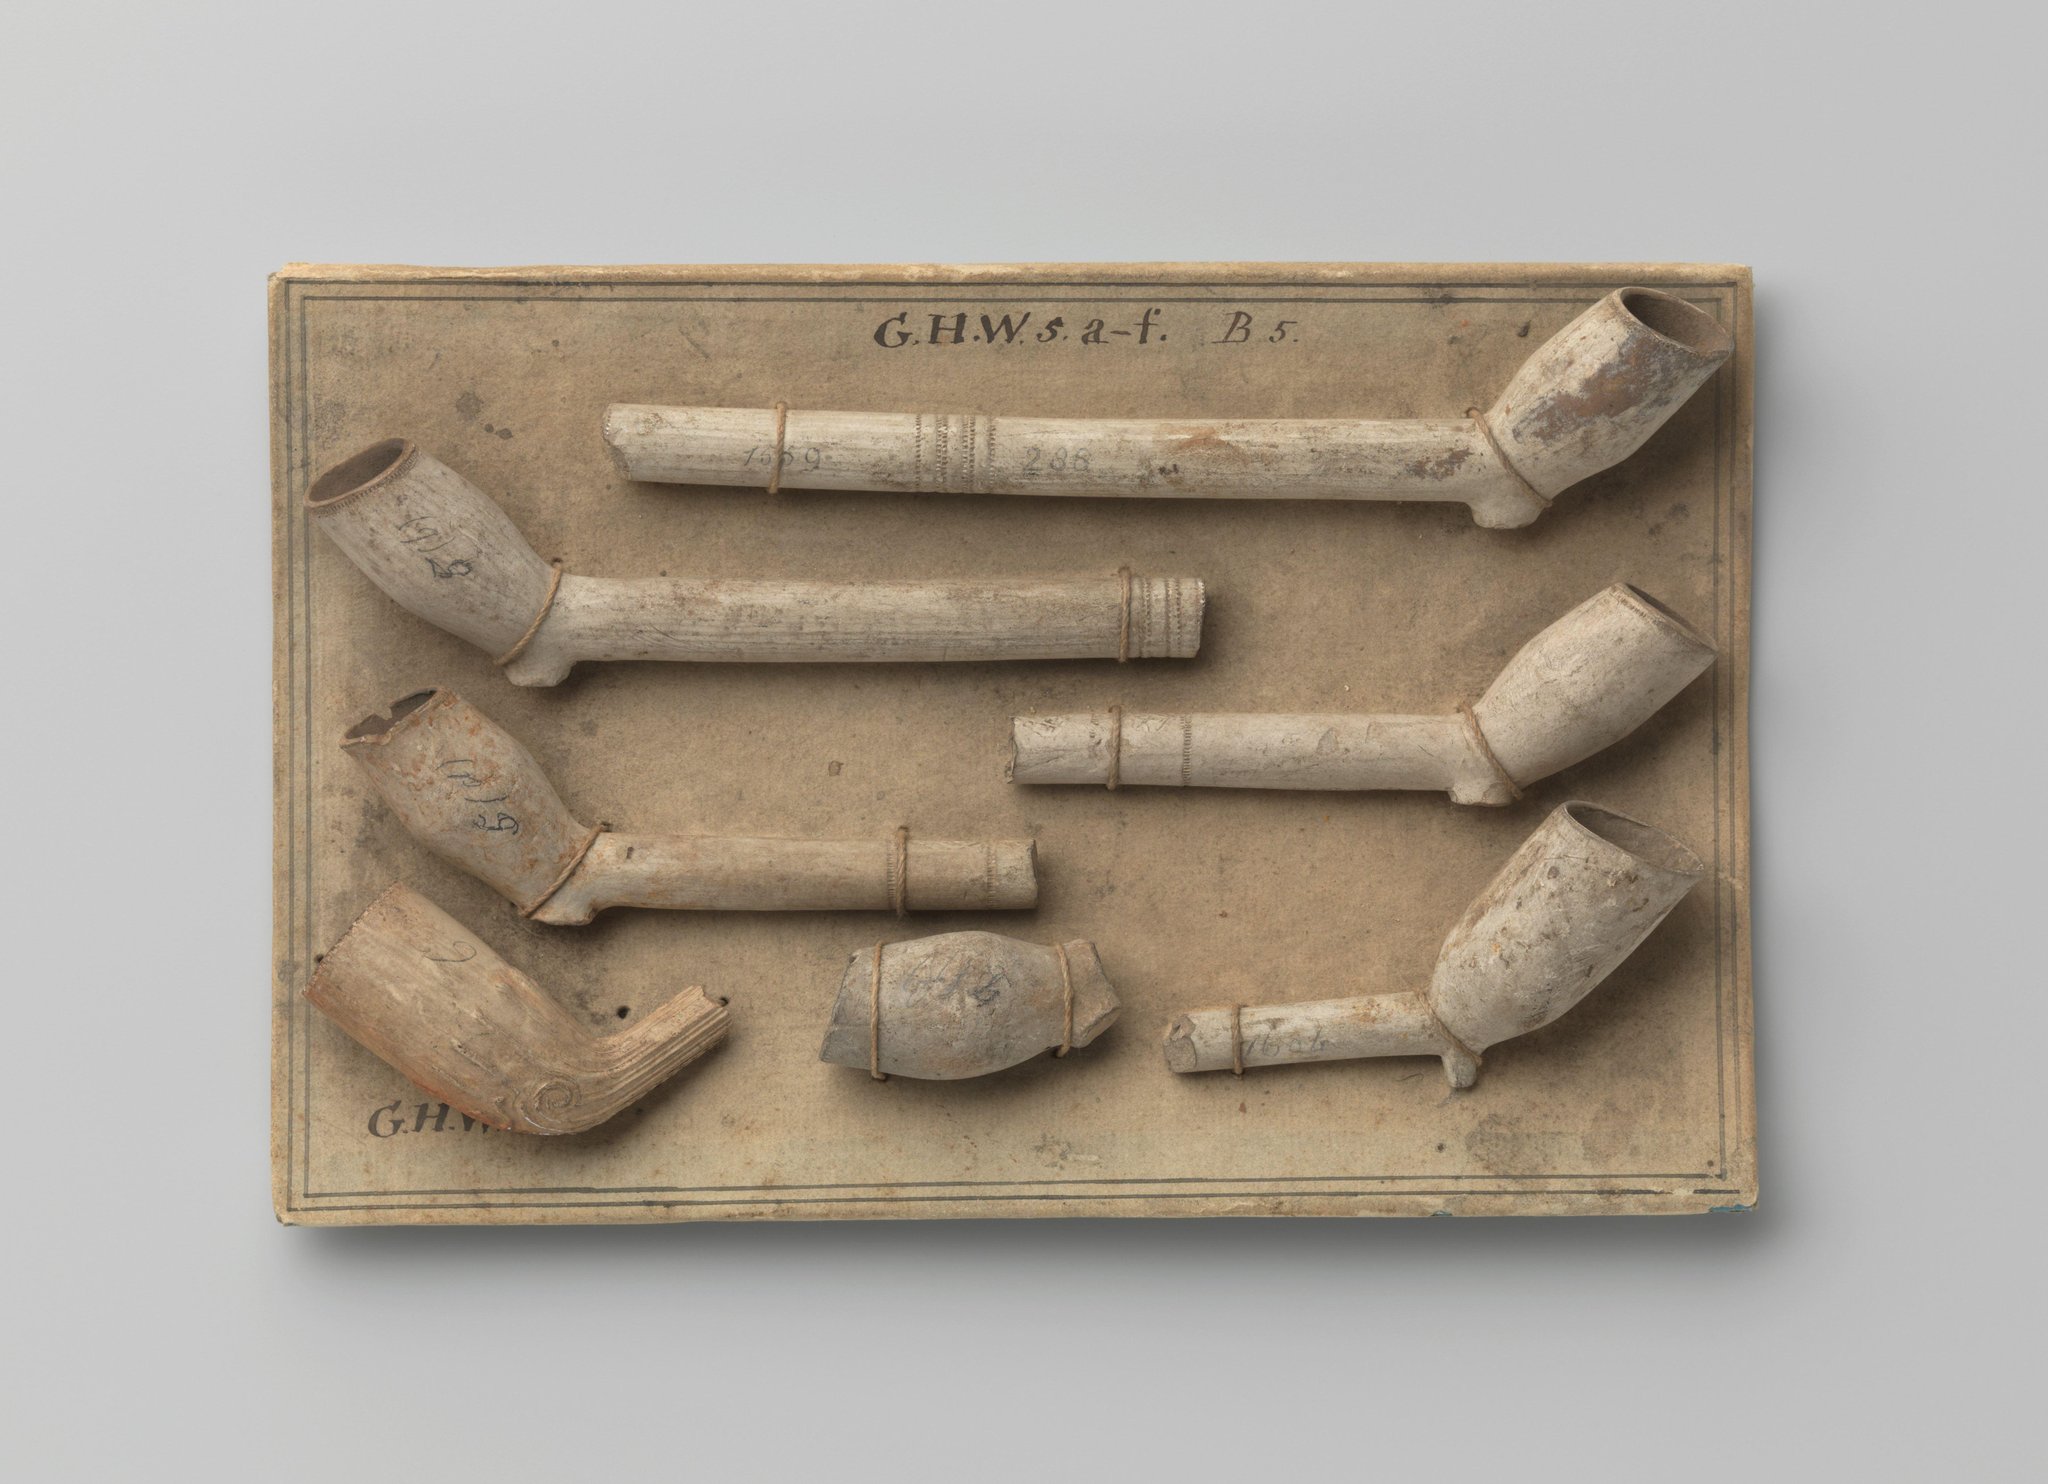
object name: pipe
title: Pijpenkop van pijpaarde.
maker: Anonymous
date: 1600-1800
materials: earthenware, clay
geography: gouda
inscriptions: : ‘G.H.W.6’, : ‘G.H.W.5 a-f B5’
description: Pijpenkop van pijpaarde. De pijpenkop is onderdeel van een serie van zeven pijpenkoppen (BK-NM-6, BK-NM-5-1 t/m BK-NM-5-6), die op een karton, voorzien van een opschrift (G.H.W.5. en G.H.W.6: initialen van de oorspronkelijke verzamelaar Heinrich Gottfried Haasloop Werner (Kleef 16 april 1792-Elburg 29 september 1864), met volgnummers), zijn gemonteerd. Zes koppen hebben een deel van een steel, een kop heeft geen steel.